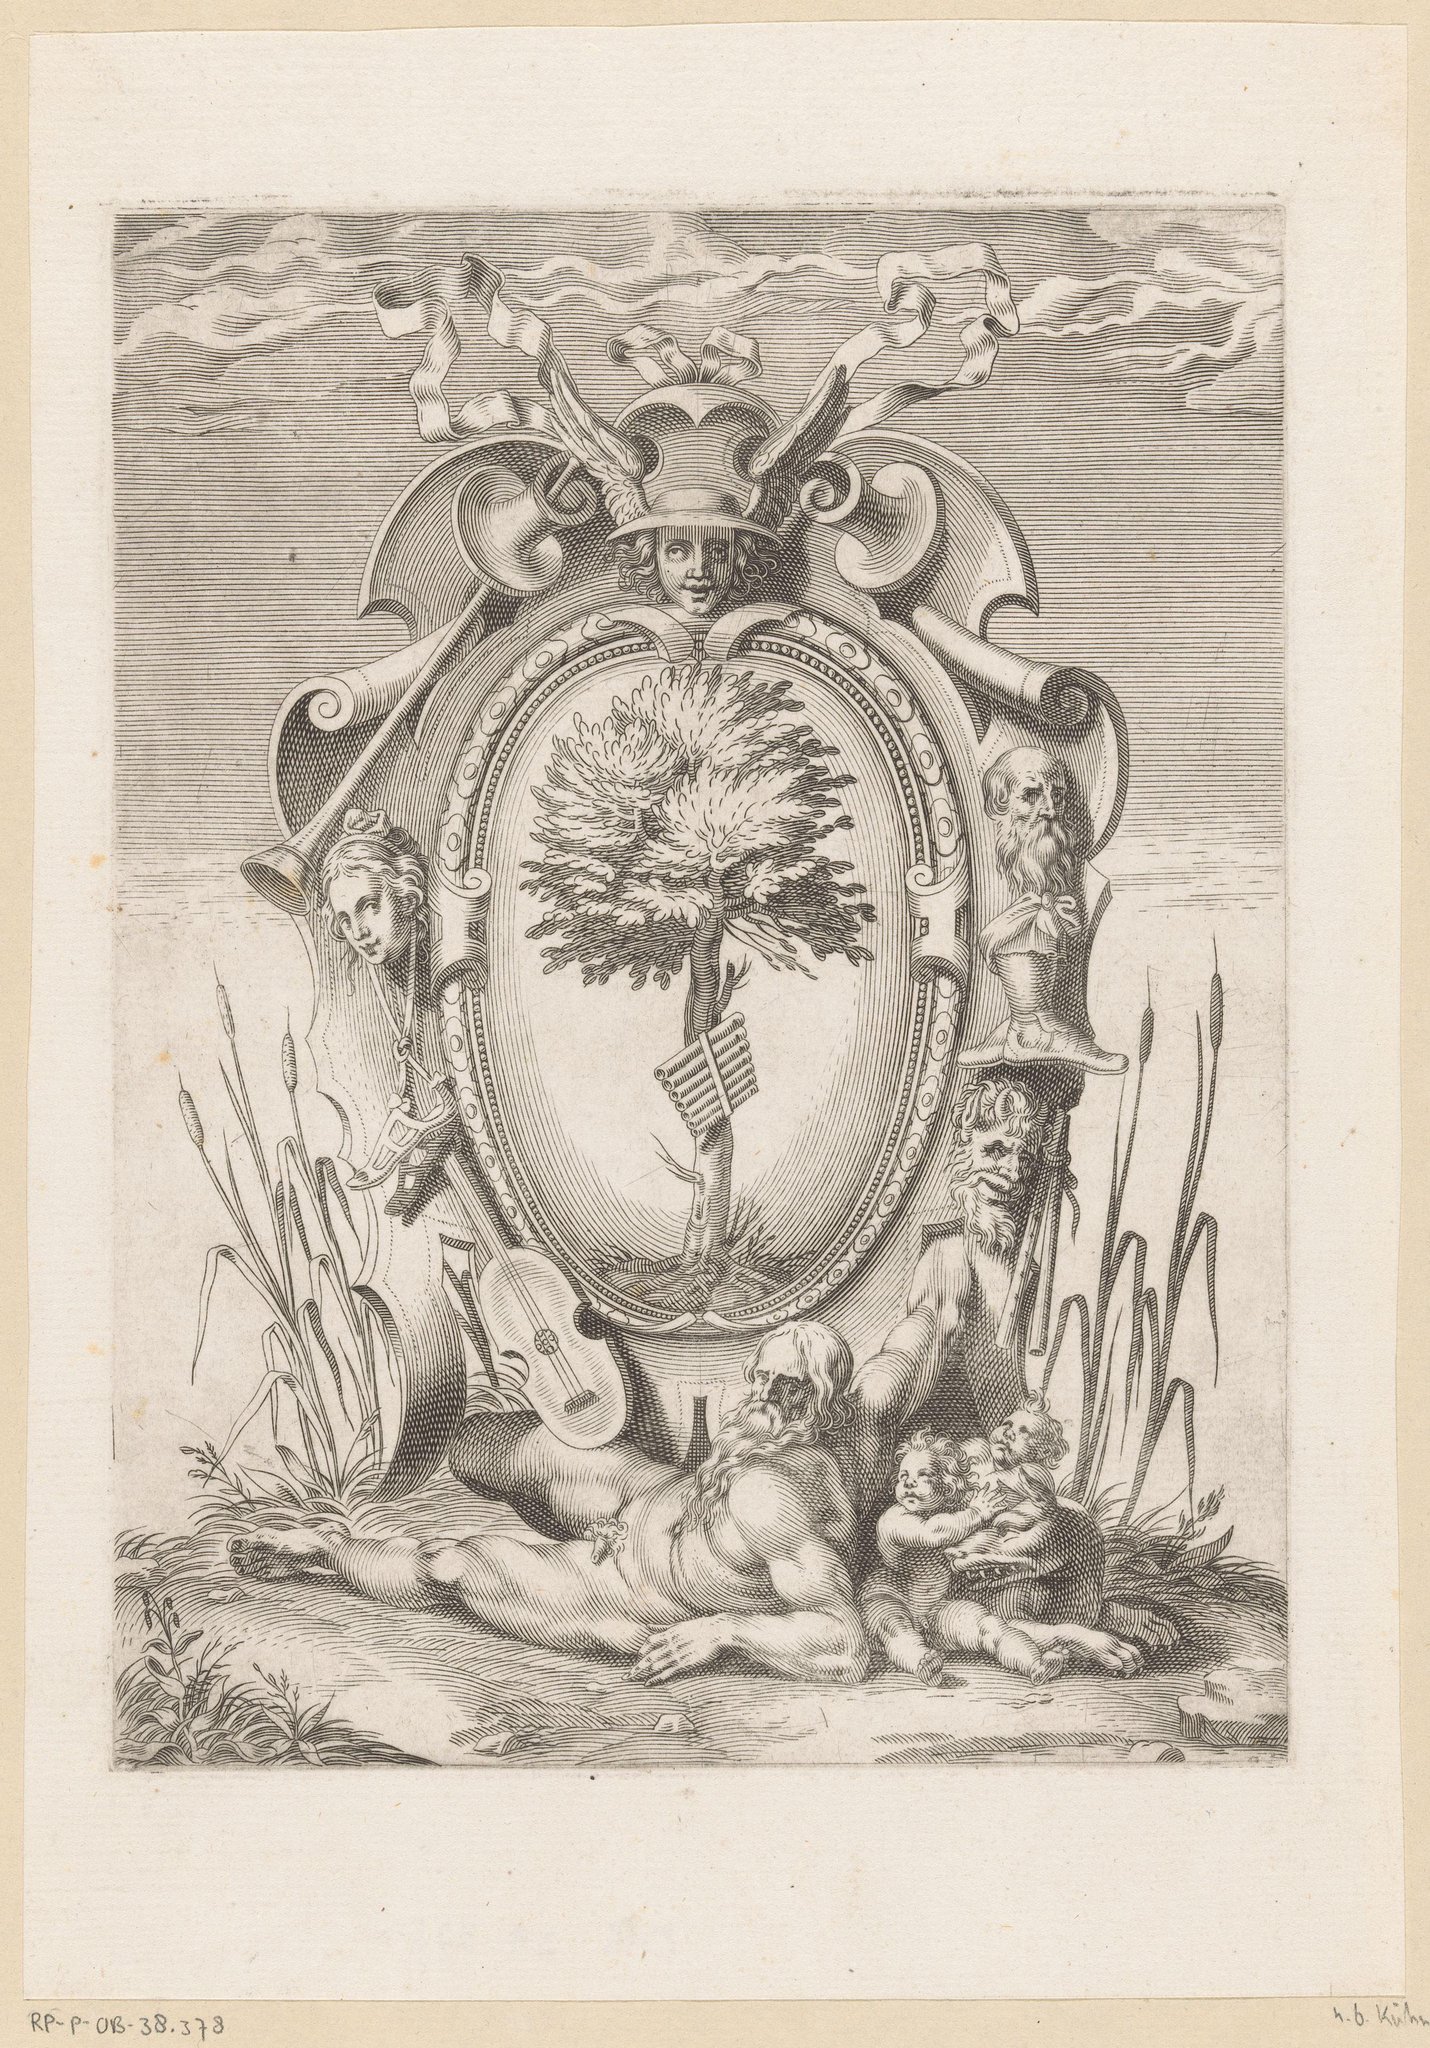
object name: print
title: Wapenschild met een panfluit aan een boom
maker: francesco villamena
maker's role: draughtsman, painter, print maker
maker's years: 1566-1624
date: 1576-1624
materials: paper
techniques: engraving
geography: italy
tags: musical instruments; group of musical instruments, panpipes, romulus and remus are washed ashore and suckled by a she-wolf; 'lupa romana', river-gods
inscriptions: collector's mark: Lugt 240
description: Wapenschild met in het midden een panfluit hangend aan een boom. Onderaan een riviergod en de wolvin met Romulus en Remus.